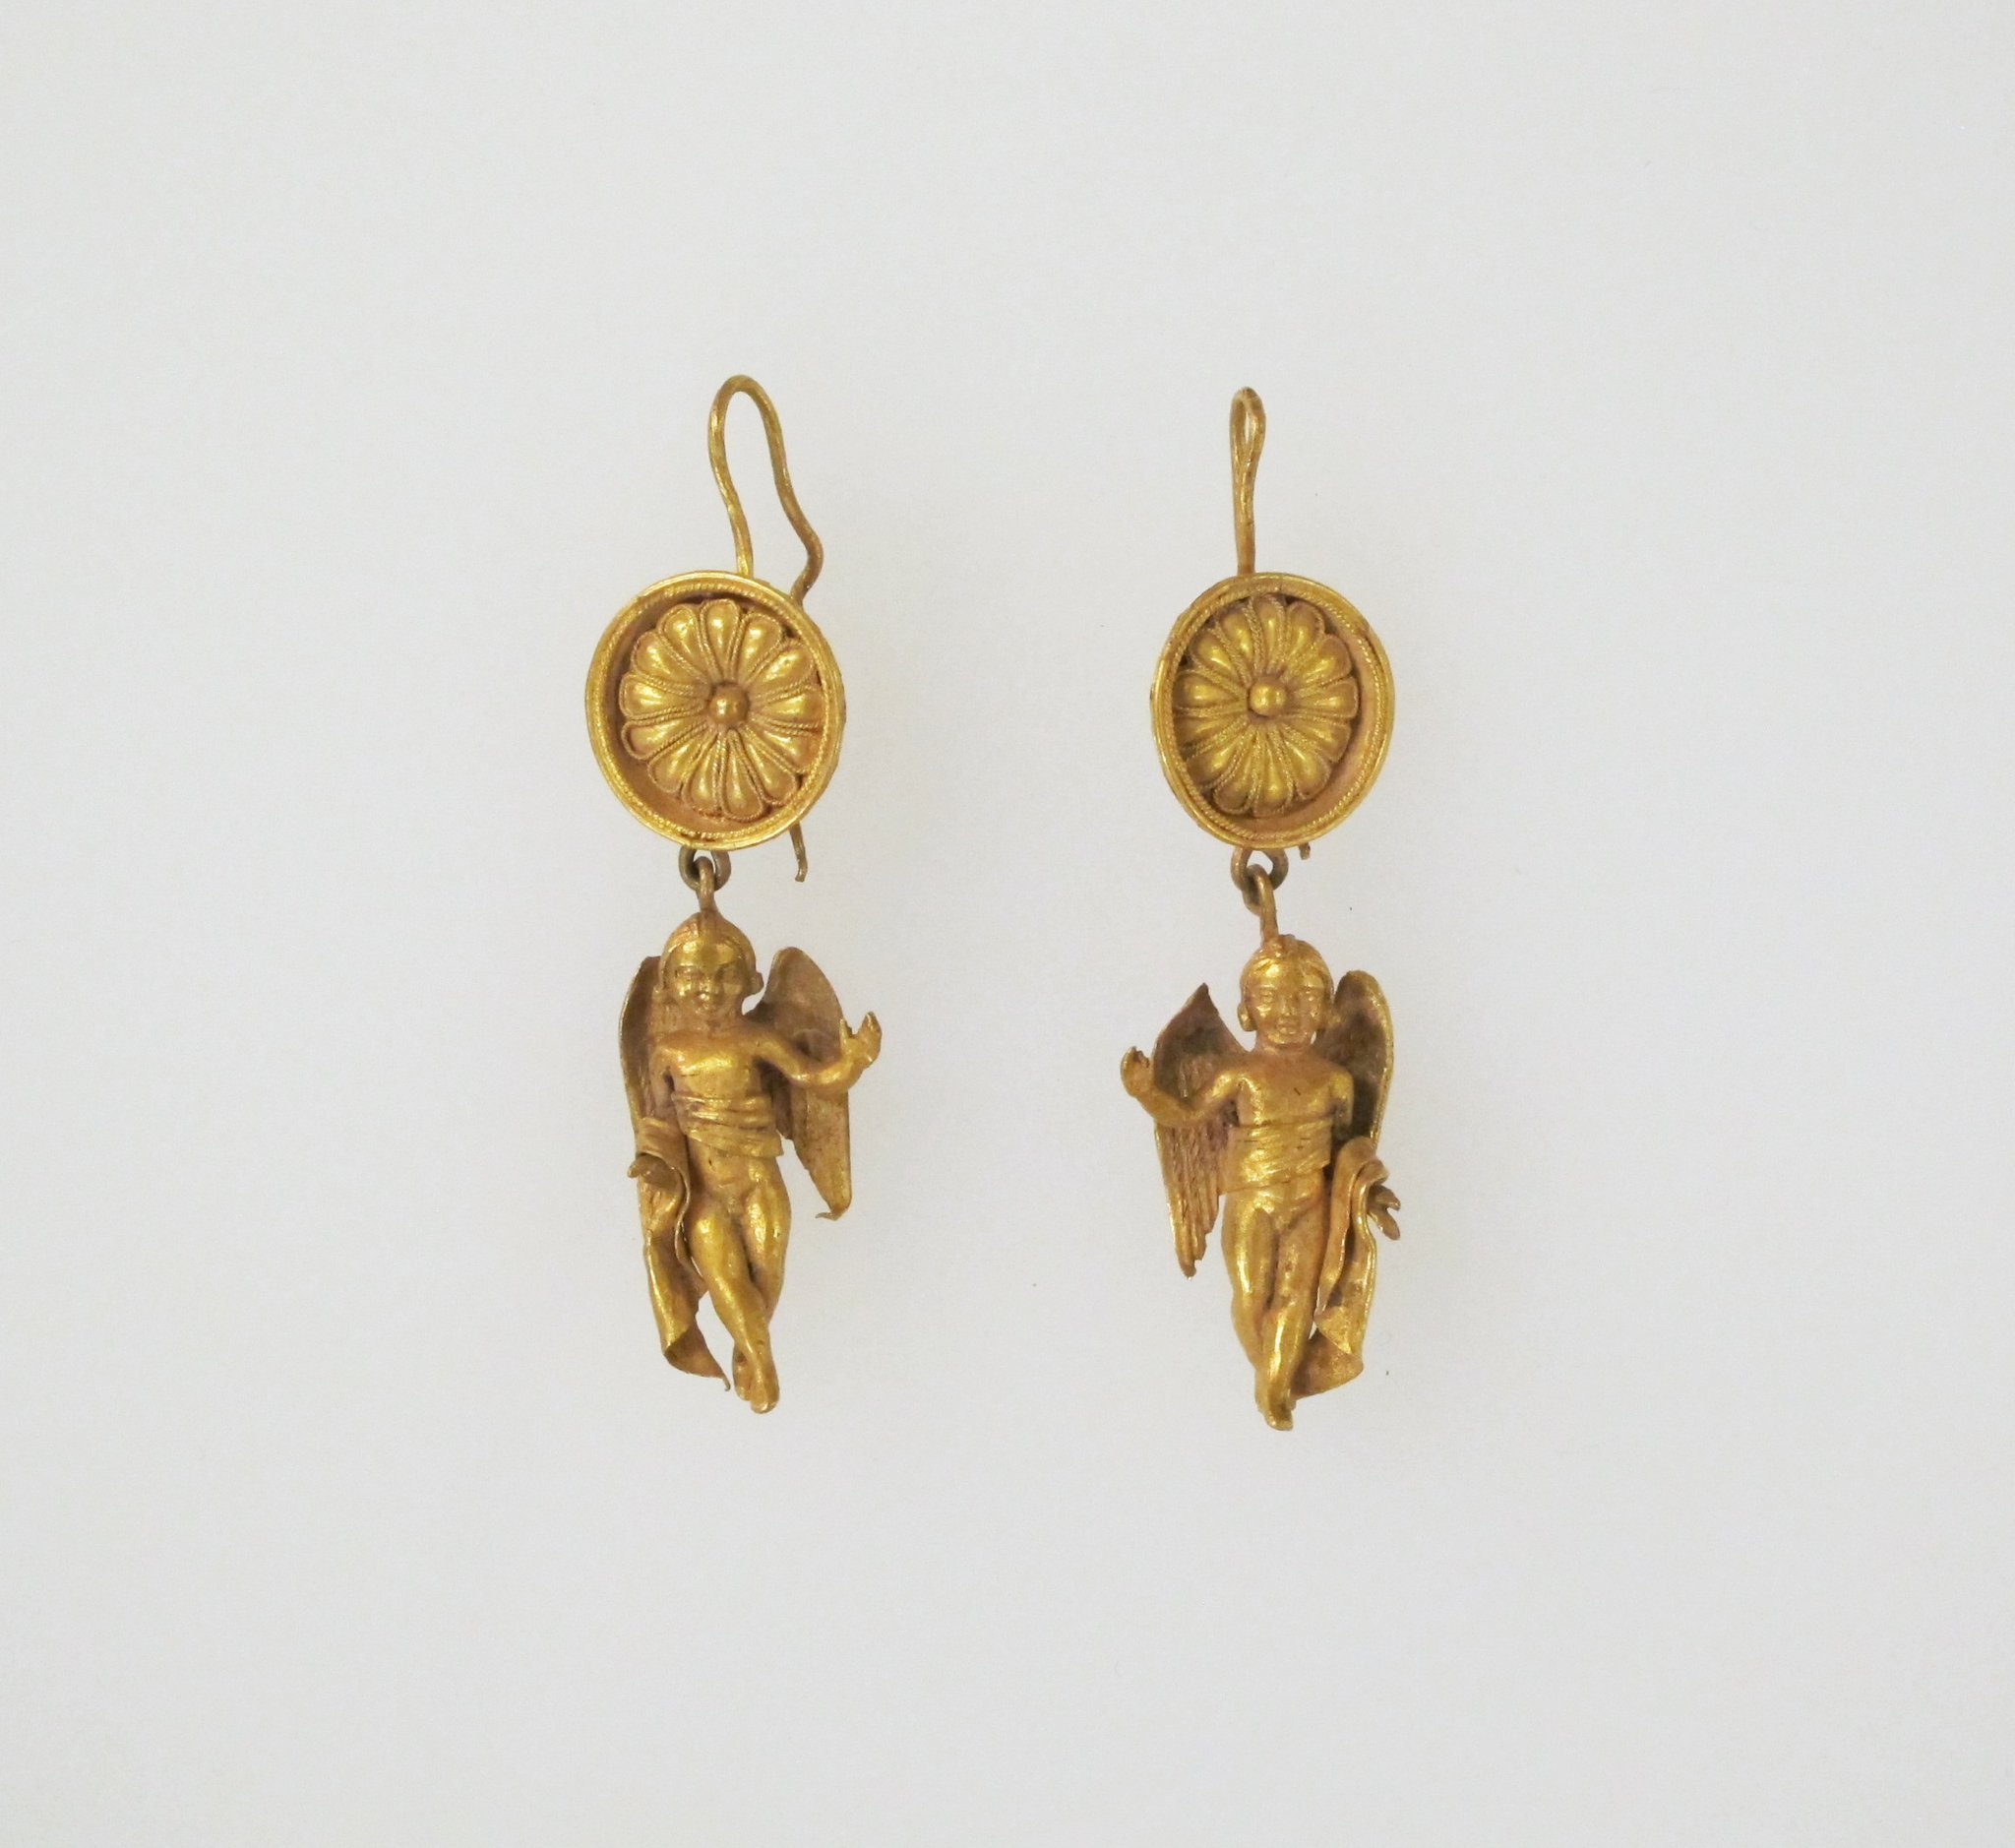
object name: earring with eros and vase pendant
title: Earring with pendant of Eros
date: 400-201 BCE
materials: gold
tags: eros